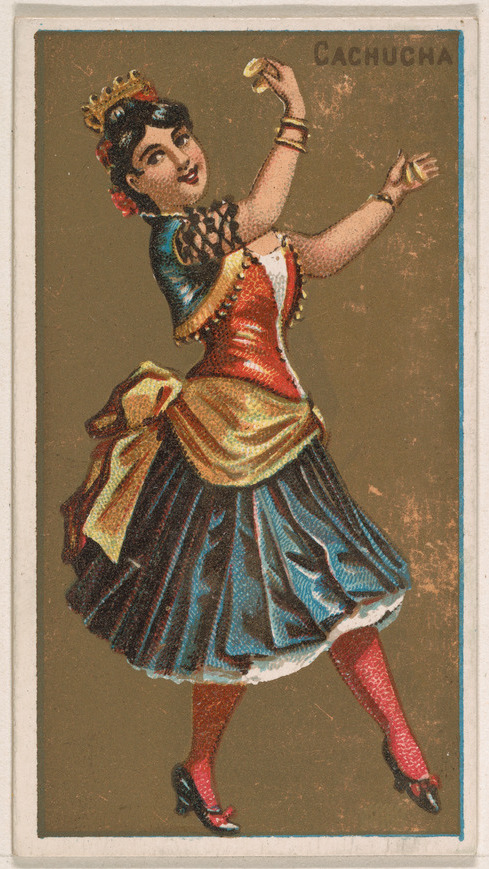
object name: print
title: Cachucha, from National Dances (N225, Type 1) issued by Kinney Bros.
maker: kinney brothers tobacco company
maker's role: publisher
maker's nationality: american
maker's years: 1869-2011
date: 1889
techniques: color lithograph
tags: women,dancers